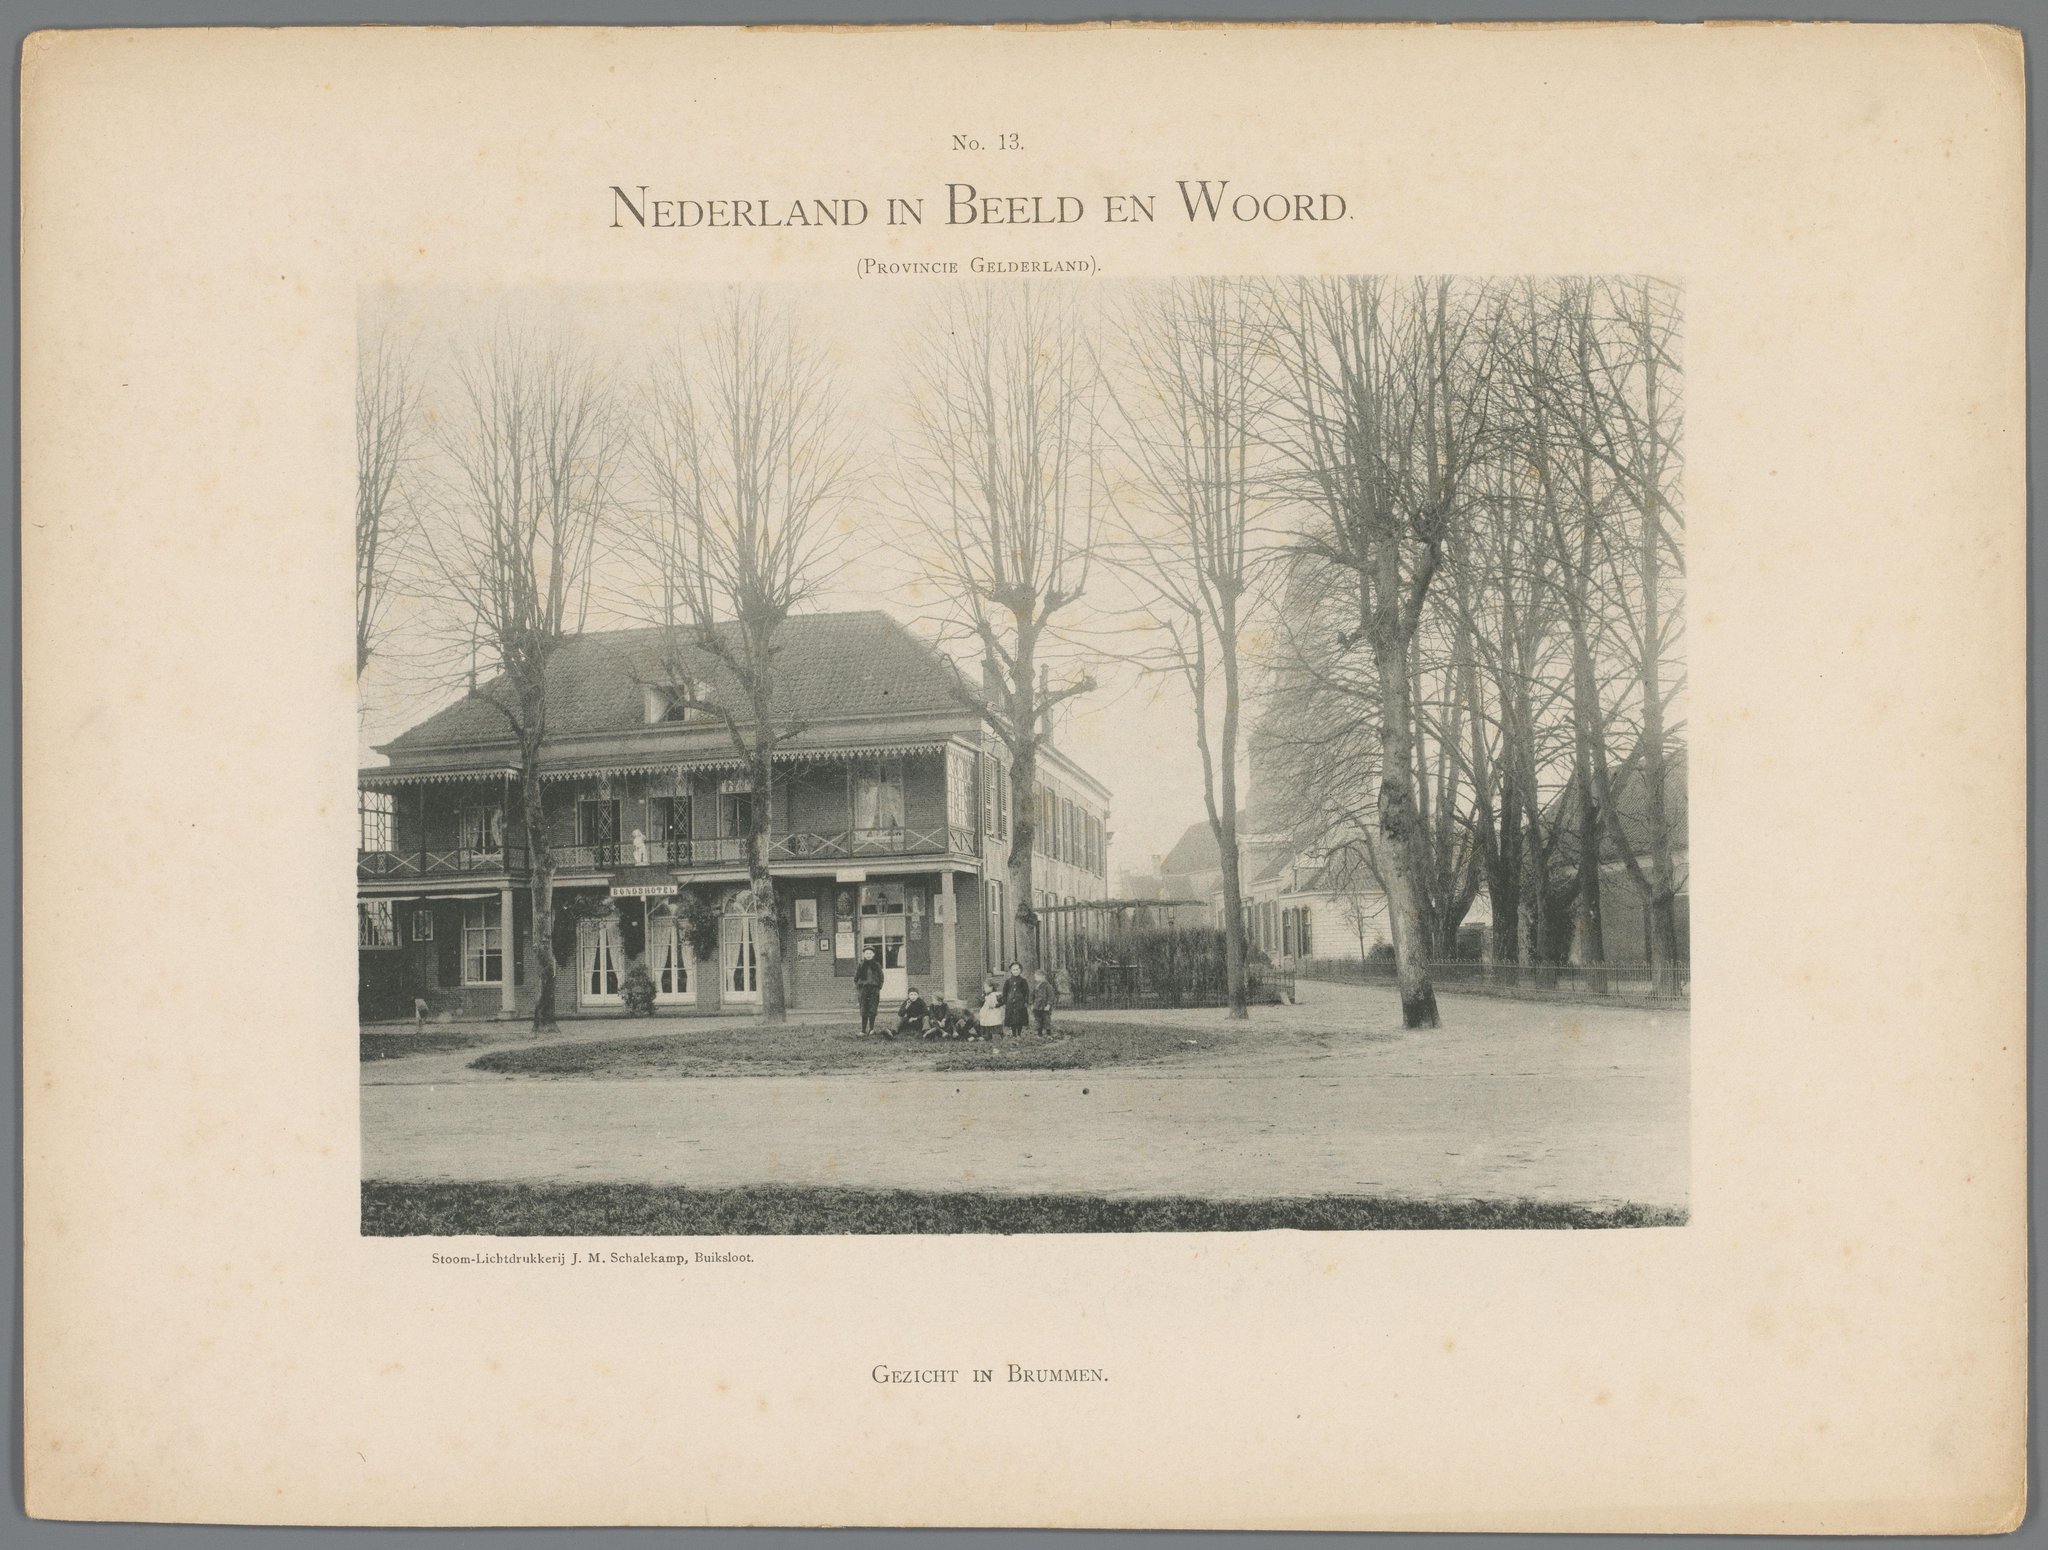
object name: photomechanical print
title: Gezicht in Brummen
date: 1890-1895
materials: cardboard, paper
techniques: photograph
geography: buiksloot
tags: exterior ~ representation of a building, hotel, hostelry, inn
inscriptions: number: ‘No. 13.’